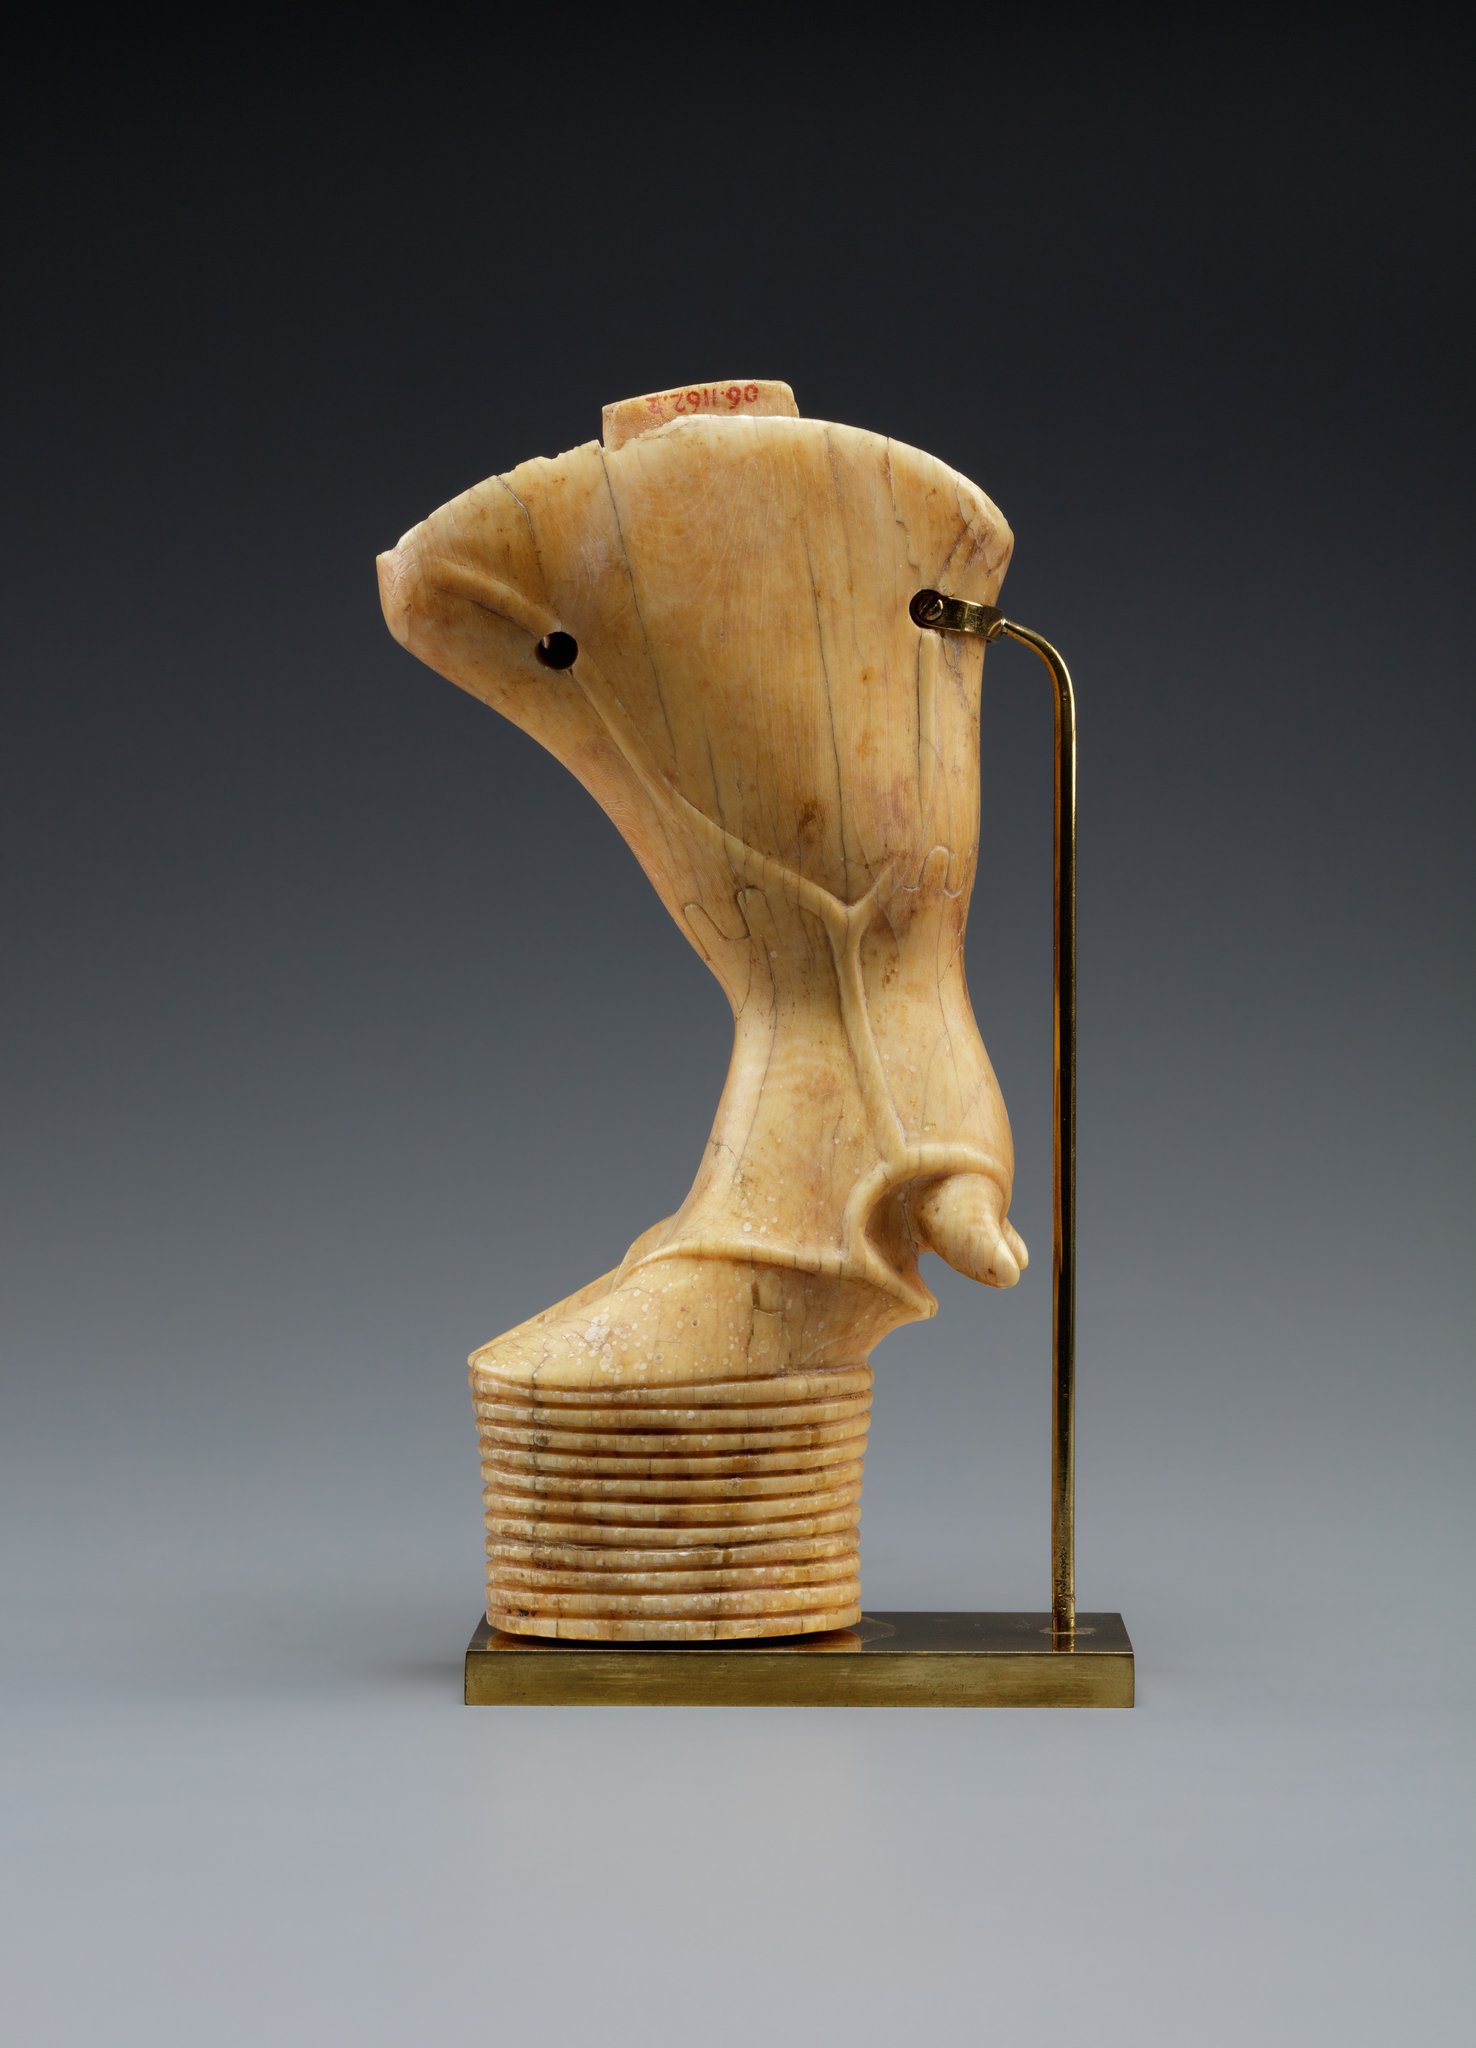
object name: furniture leg, bull's leg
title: Bull's leg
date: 2960-2770 BCE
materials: ivory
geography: northern upper egypt